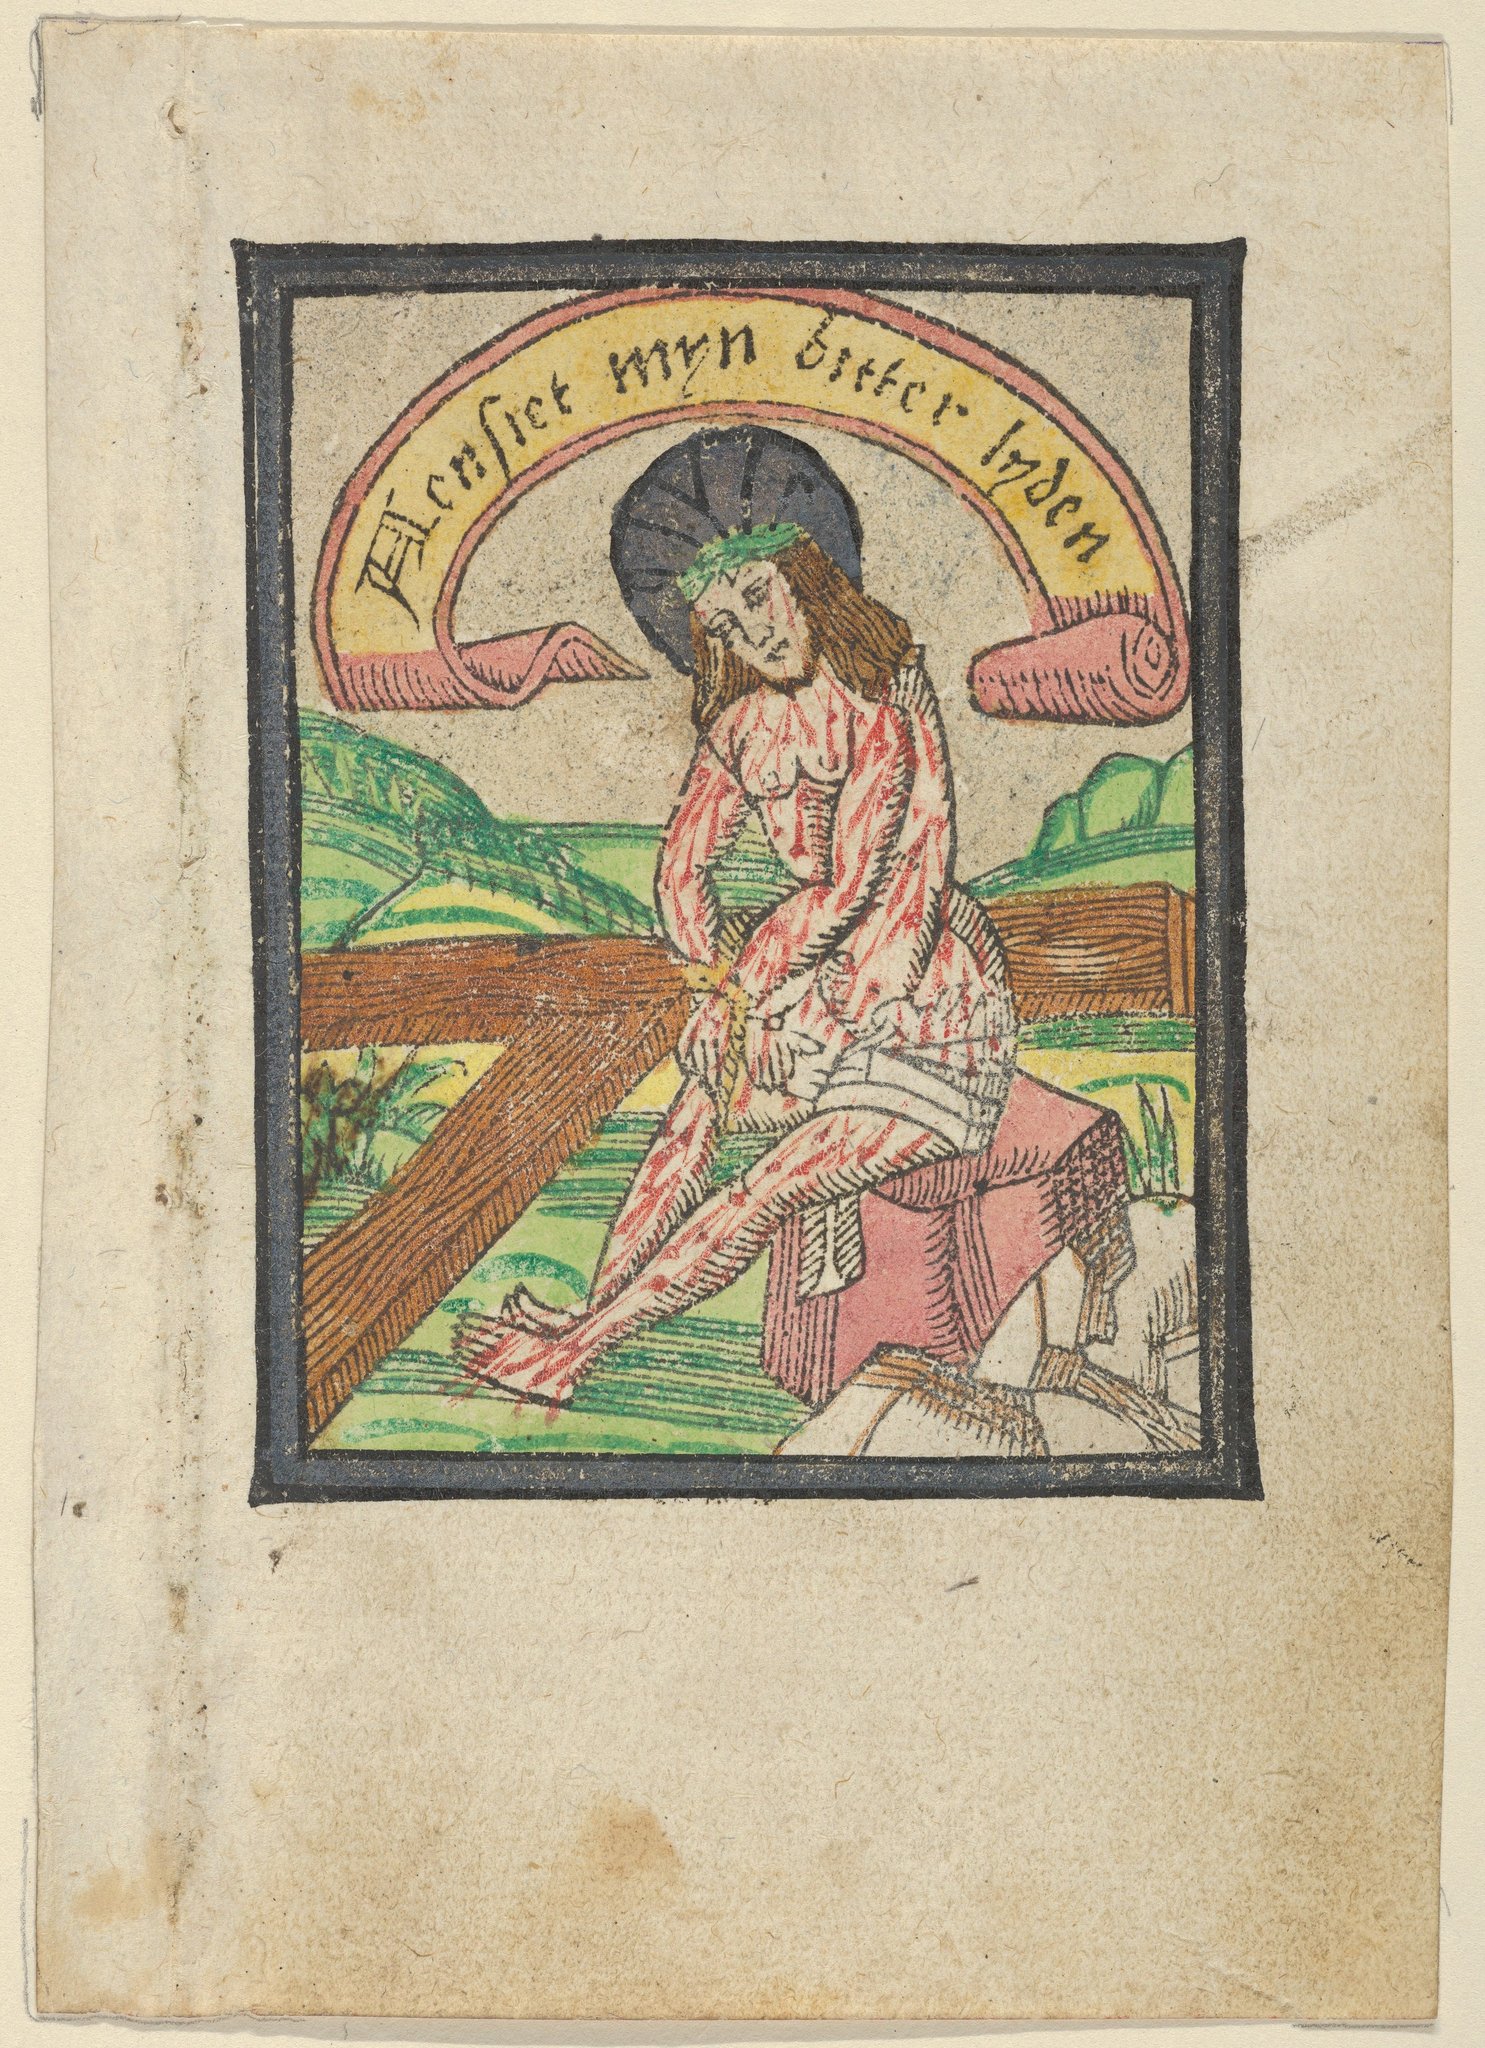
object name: print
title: Man of Sorrows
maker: anonymous, netherlandish, 15th century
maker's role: artist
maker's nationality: netherlandish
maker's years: 1400-1500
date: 1401-1500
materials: silver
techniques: hand coloring, woodcut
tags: sadness,christ